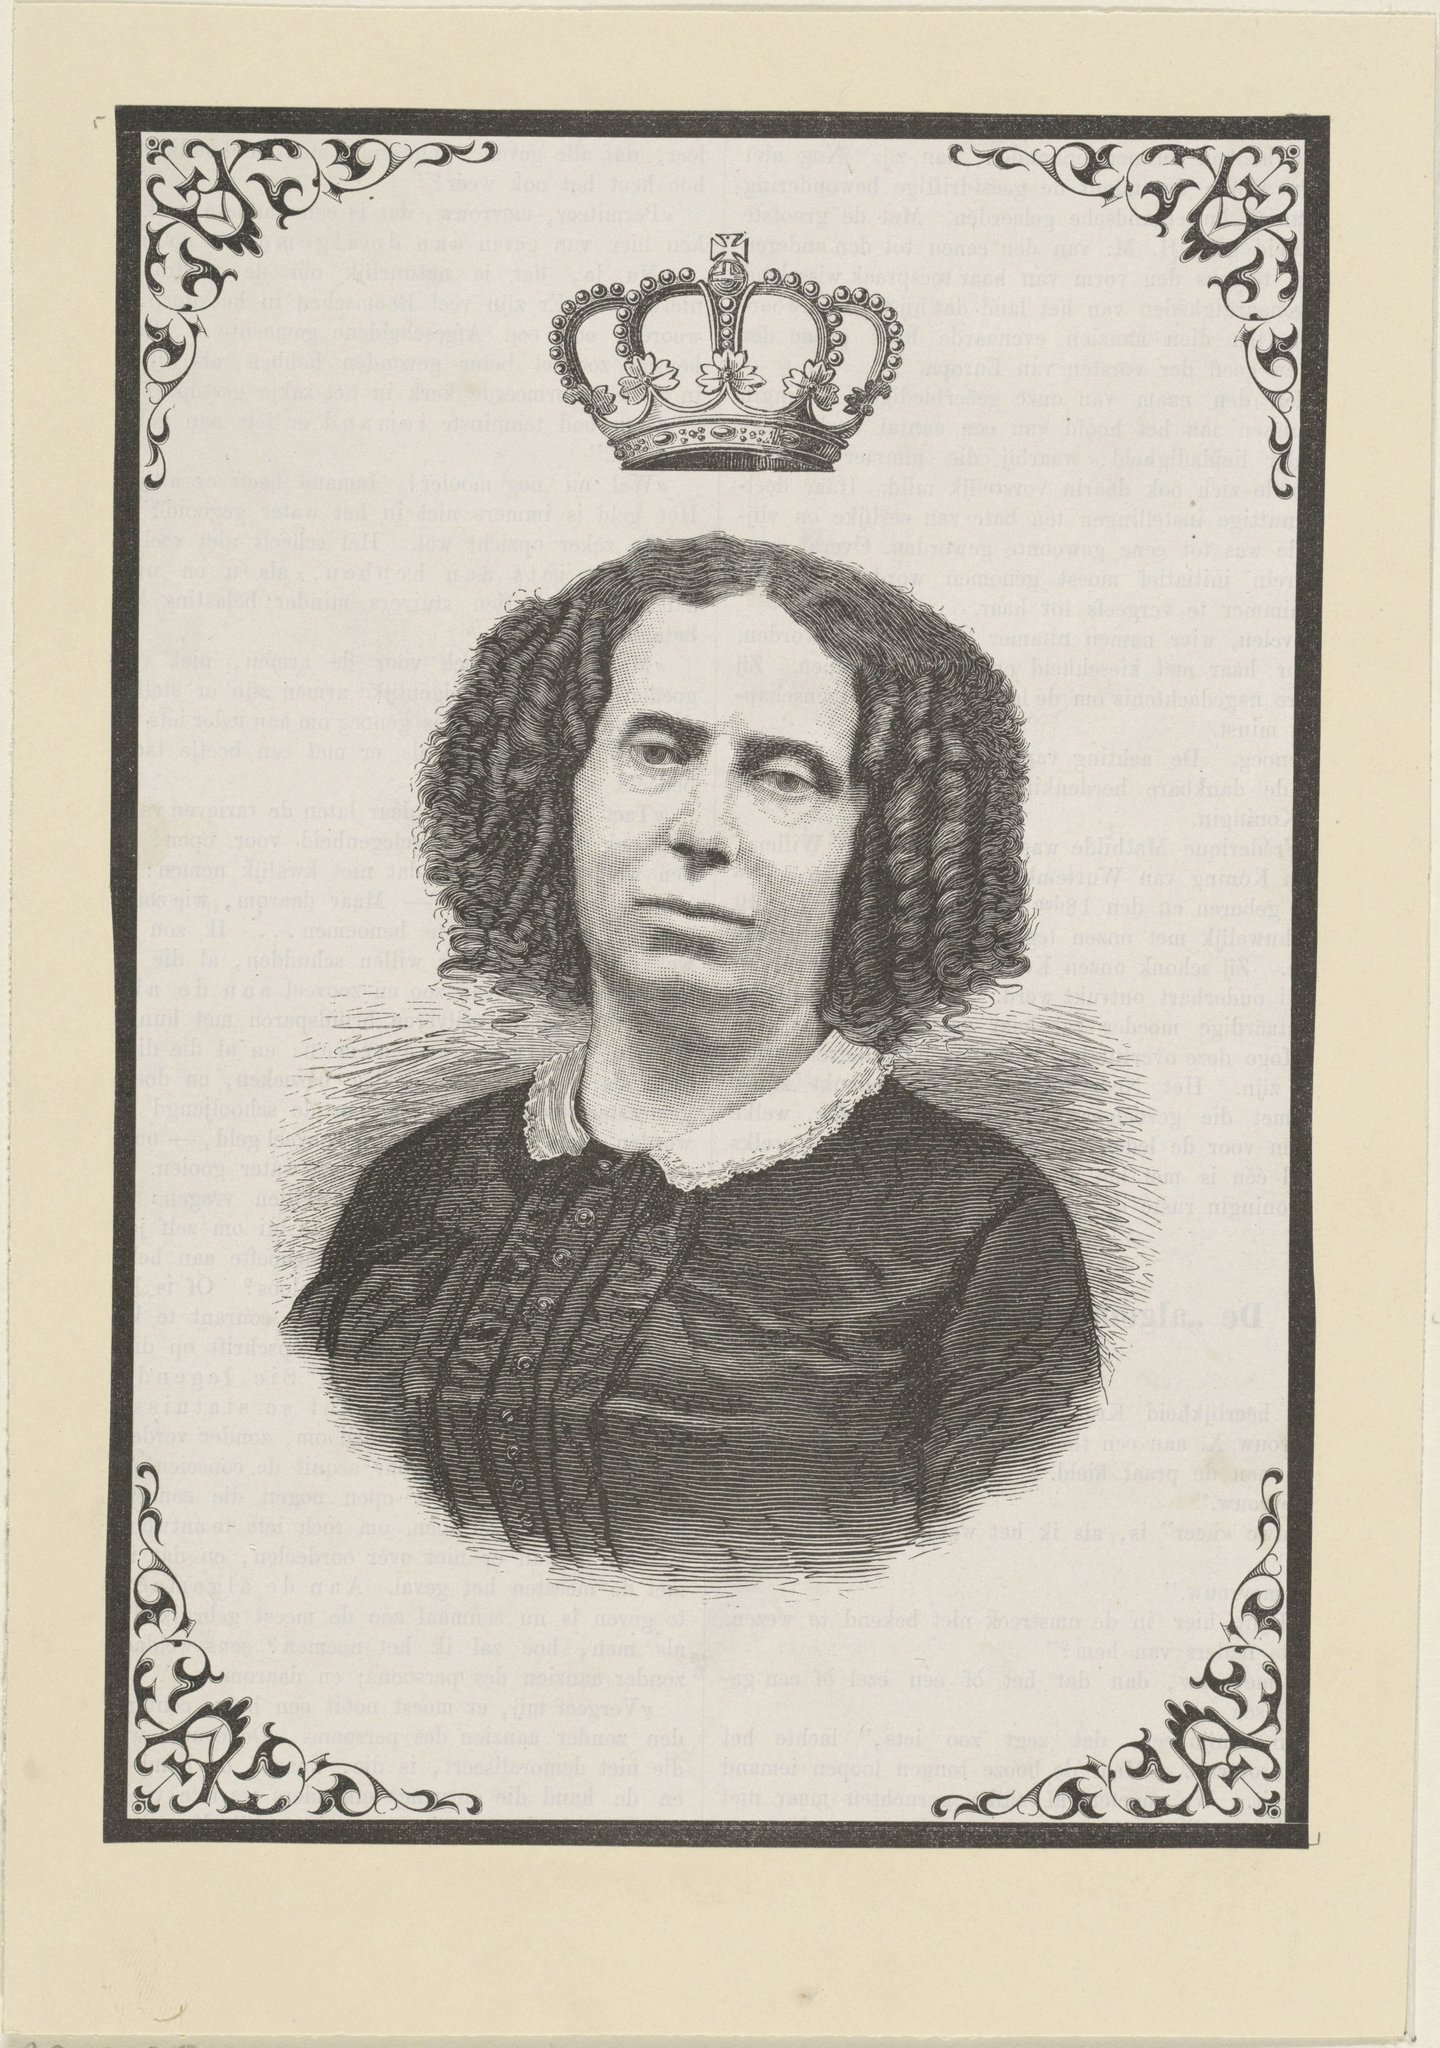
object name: book illustration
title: Portret van Sophie van Württemberg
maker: Anonymous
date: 1849-1899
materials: paper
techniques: letterpress printing, engraving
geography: netherlands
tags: the hague, sophia frederika mathilda van württemberg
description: Portret van Sophie. Midden boven een kroon. Geheel in een geornamenteerde rechthoek.